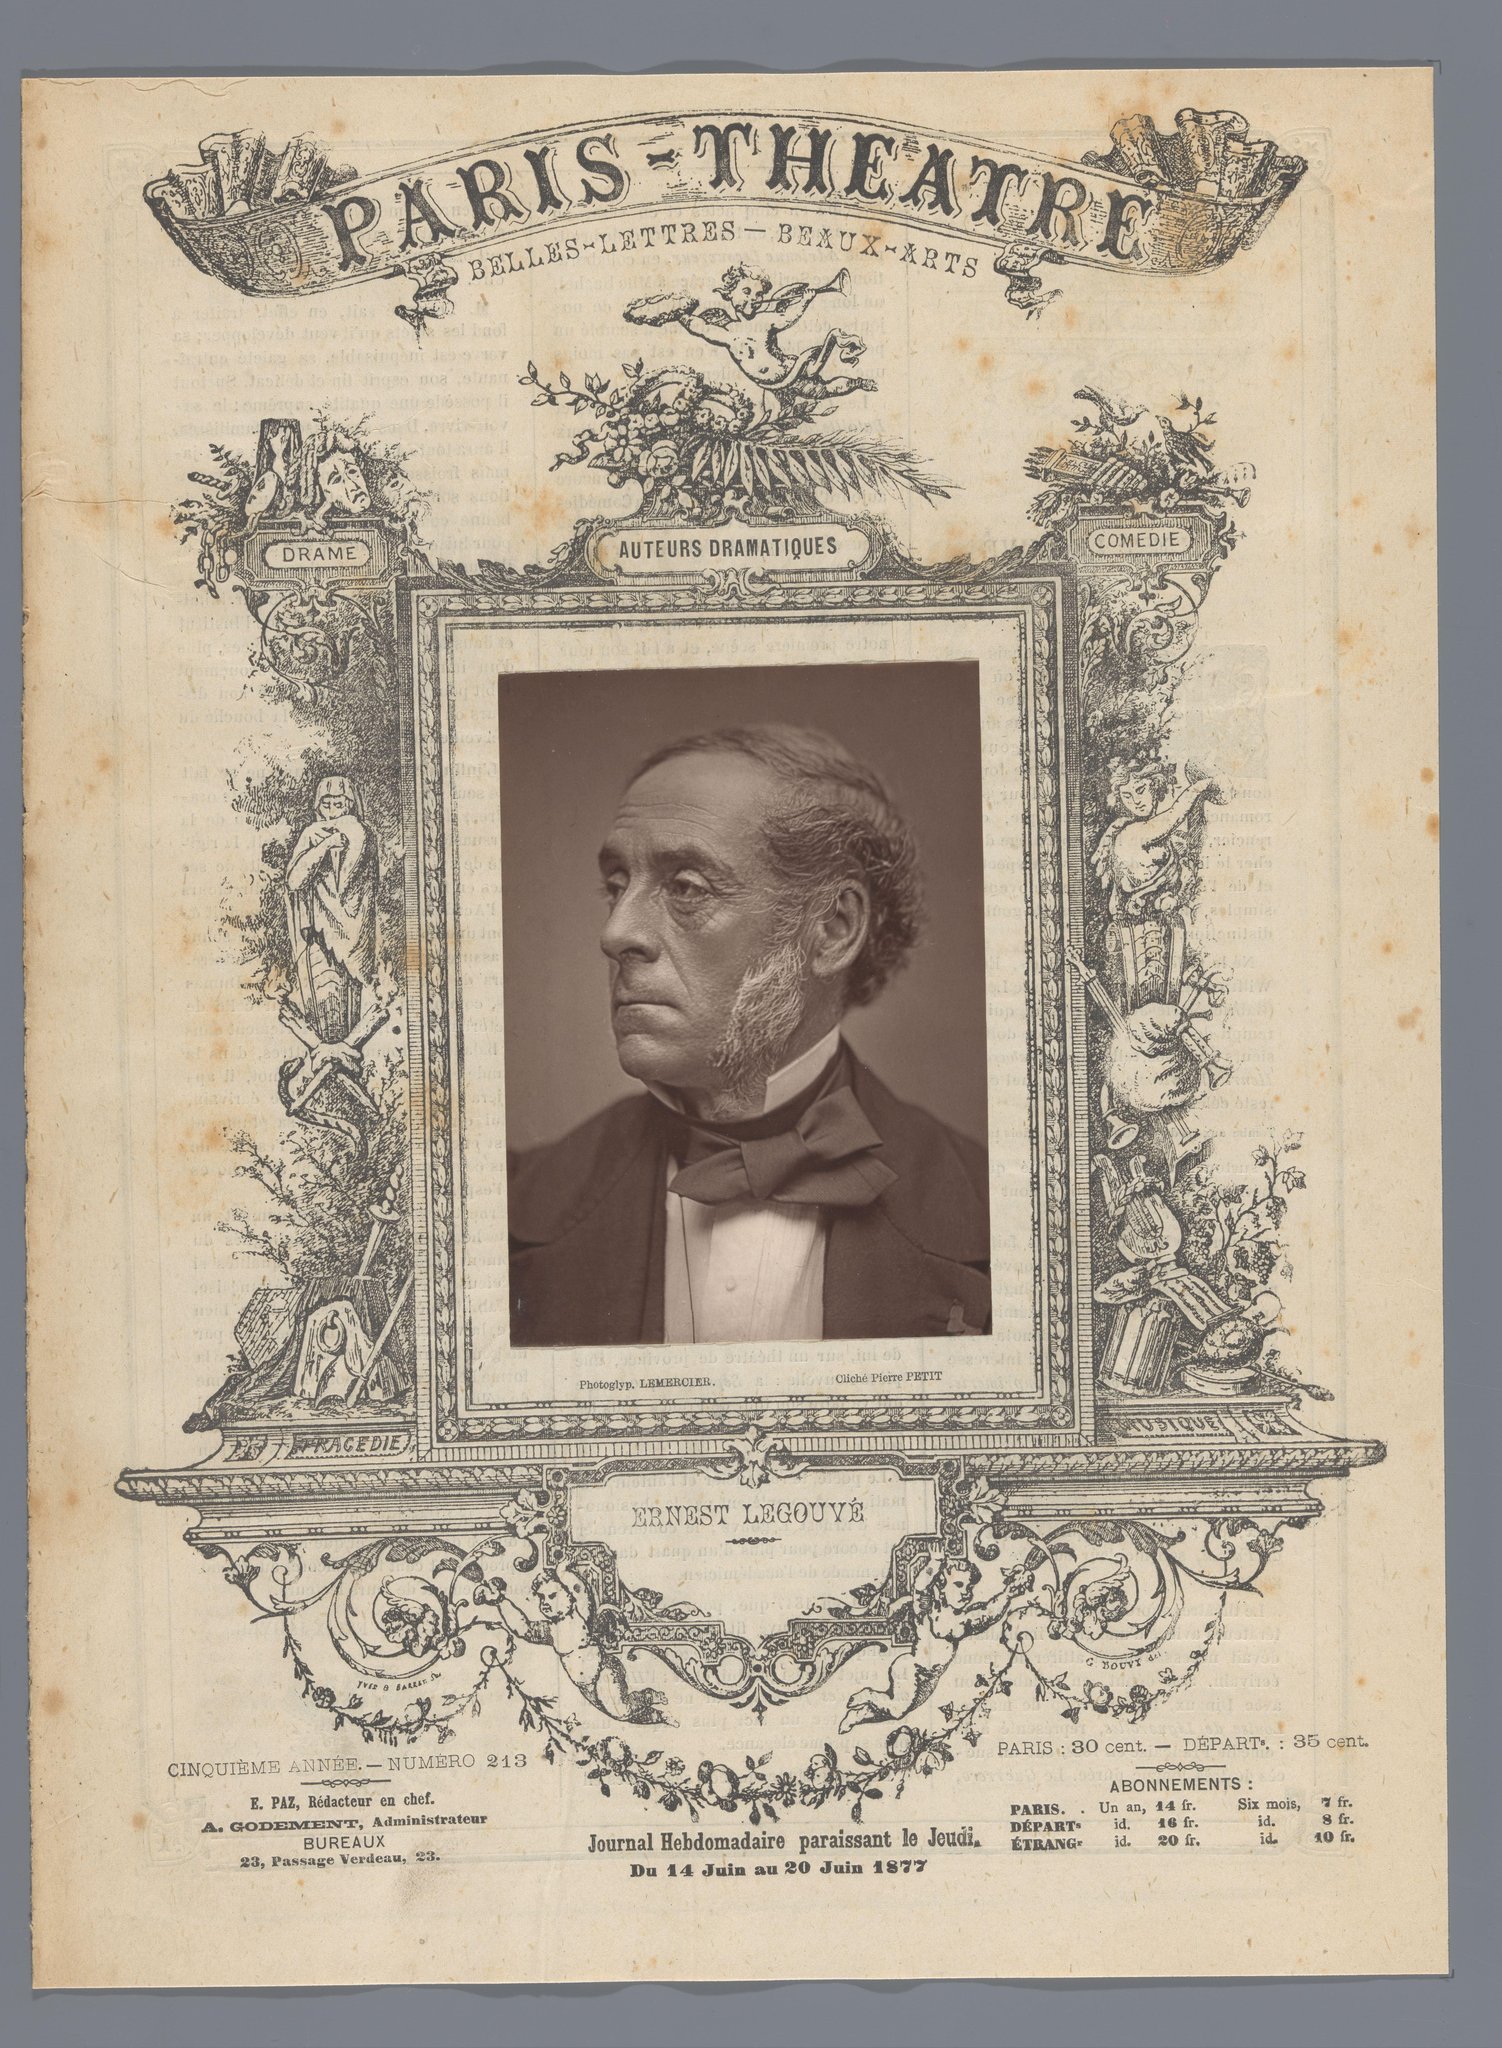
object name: photomechanical print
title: Ernest Legouve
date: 1872-1879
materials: paper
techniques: woodburytype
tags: historical persons